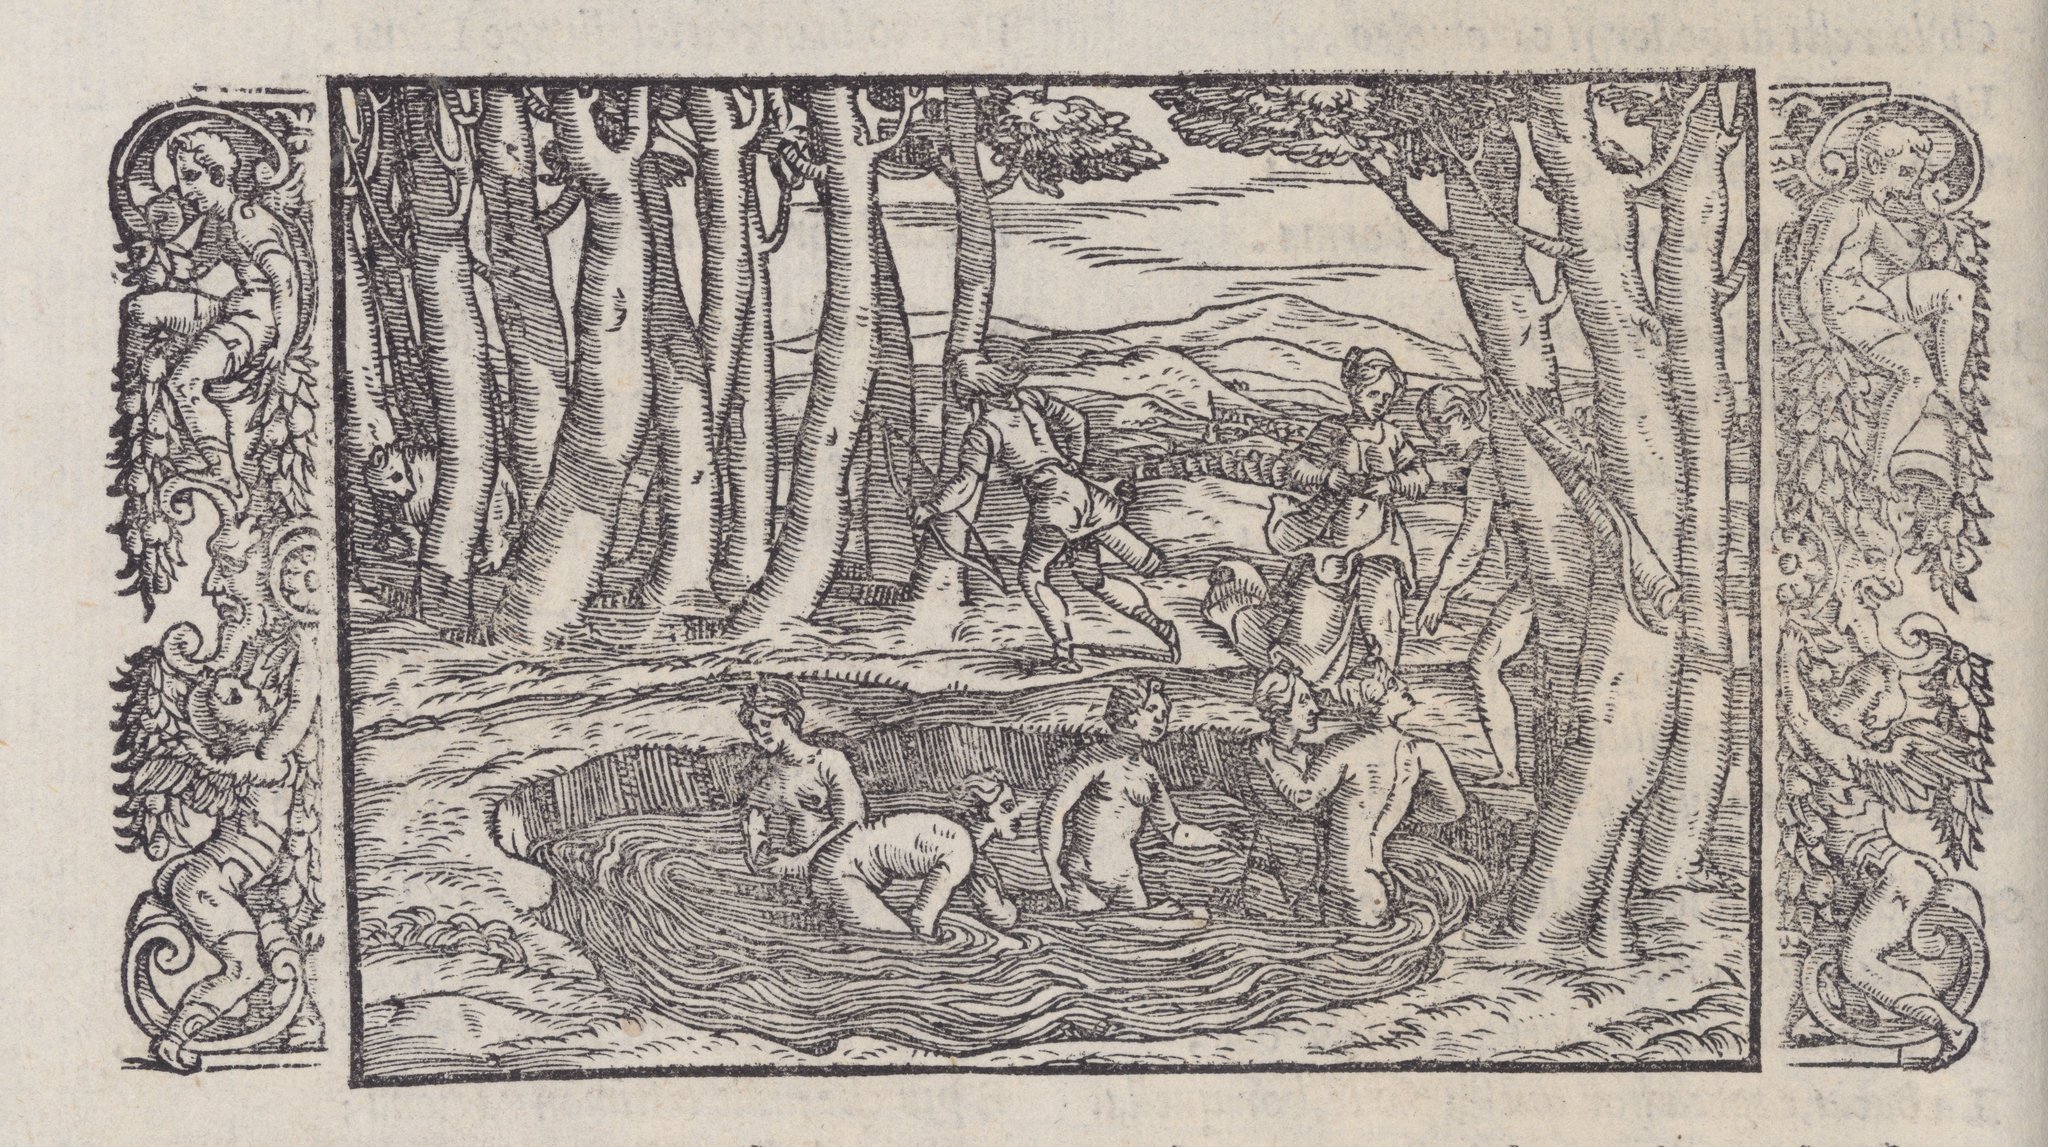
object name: book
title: Le Trasformationi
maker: ovid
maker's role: author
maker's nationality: roman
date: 1558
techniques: printing, woodcut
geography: italy